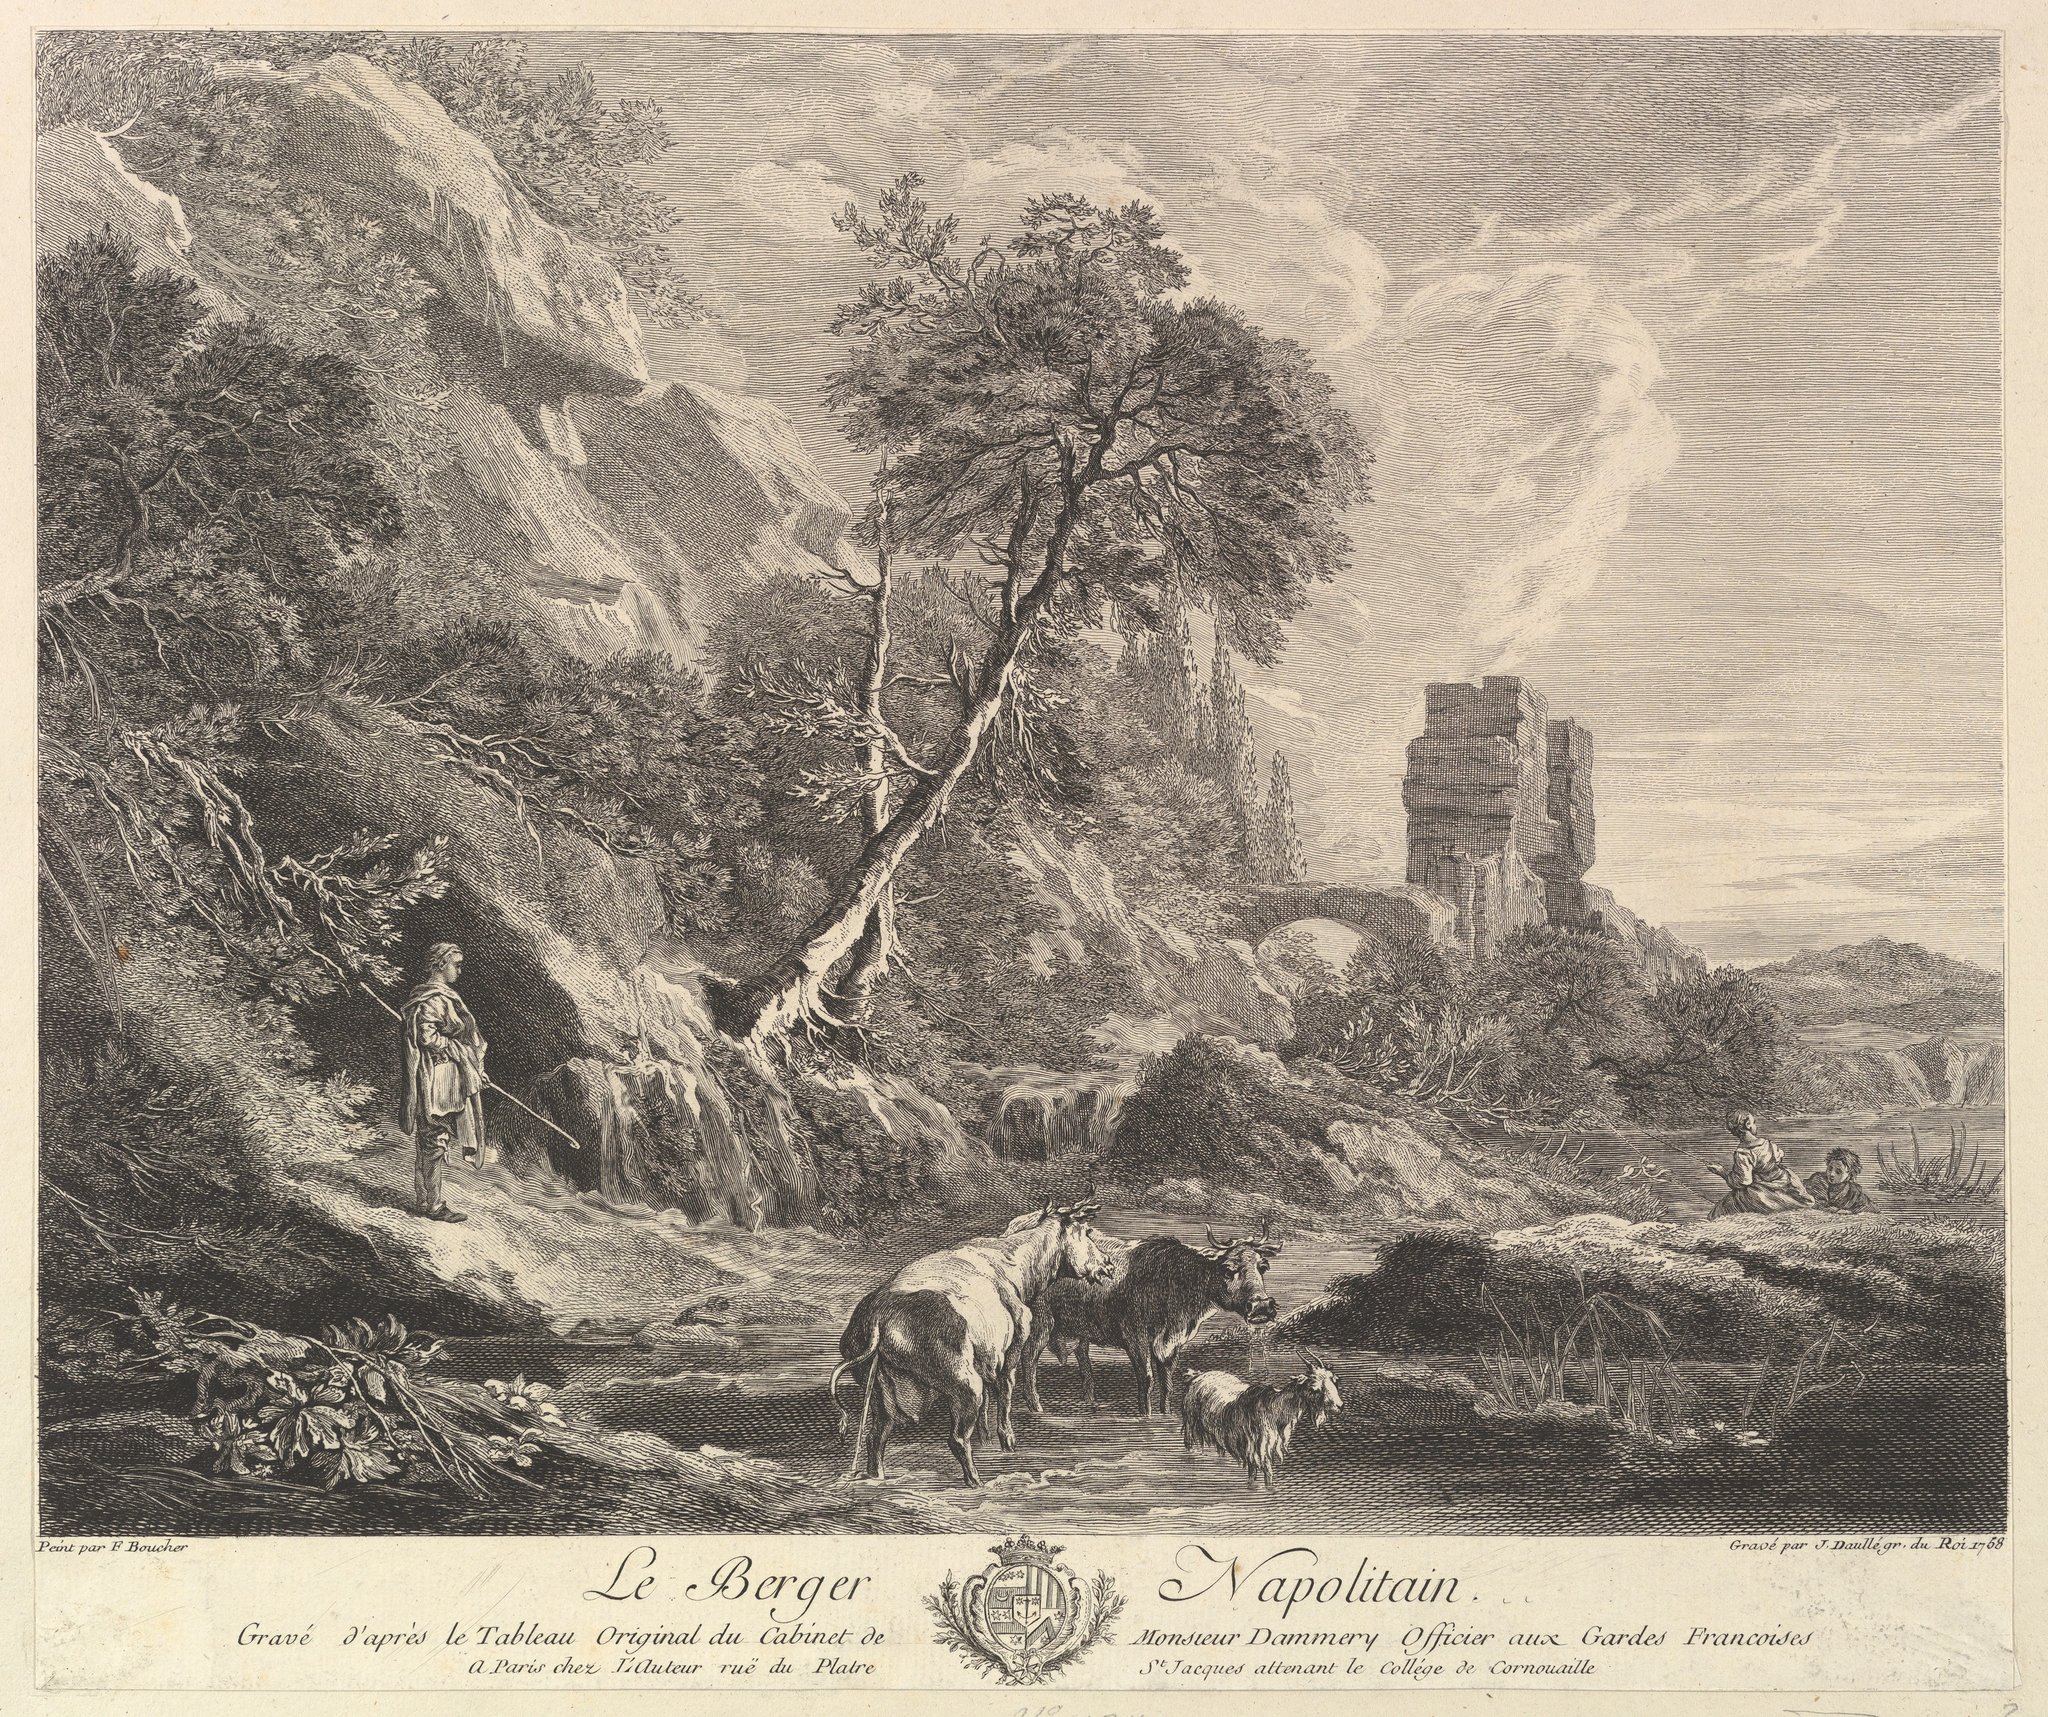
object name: print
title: Neapolitan Shepherd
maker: jean daullé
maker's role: artist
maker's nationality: french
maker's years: 1703-1763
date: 1758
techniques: engraving, etching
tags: cows,shepherds